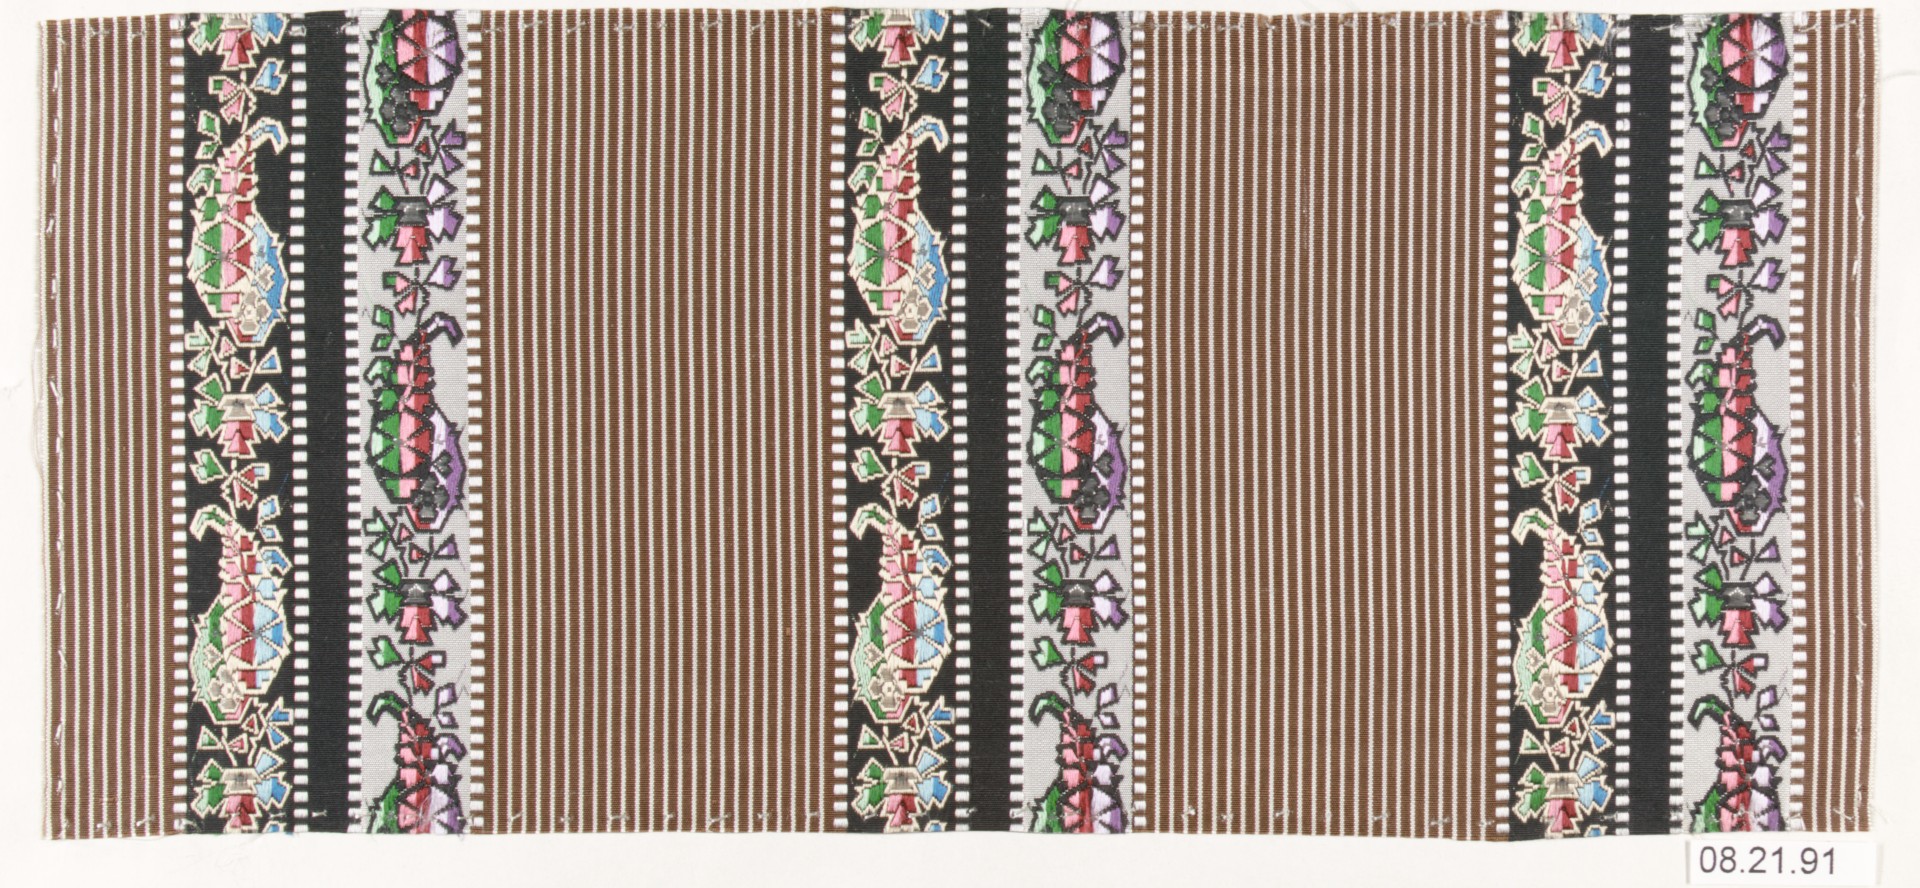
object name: textile sample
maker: Anonymous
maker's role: designer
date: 1900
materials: silk